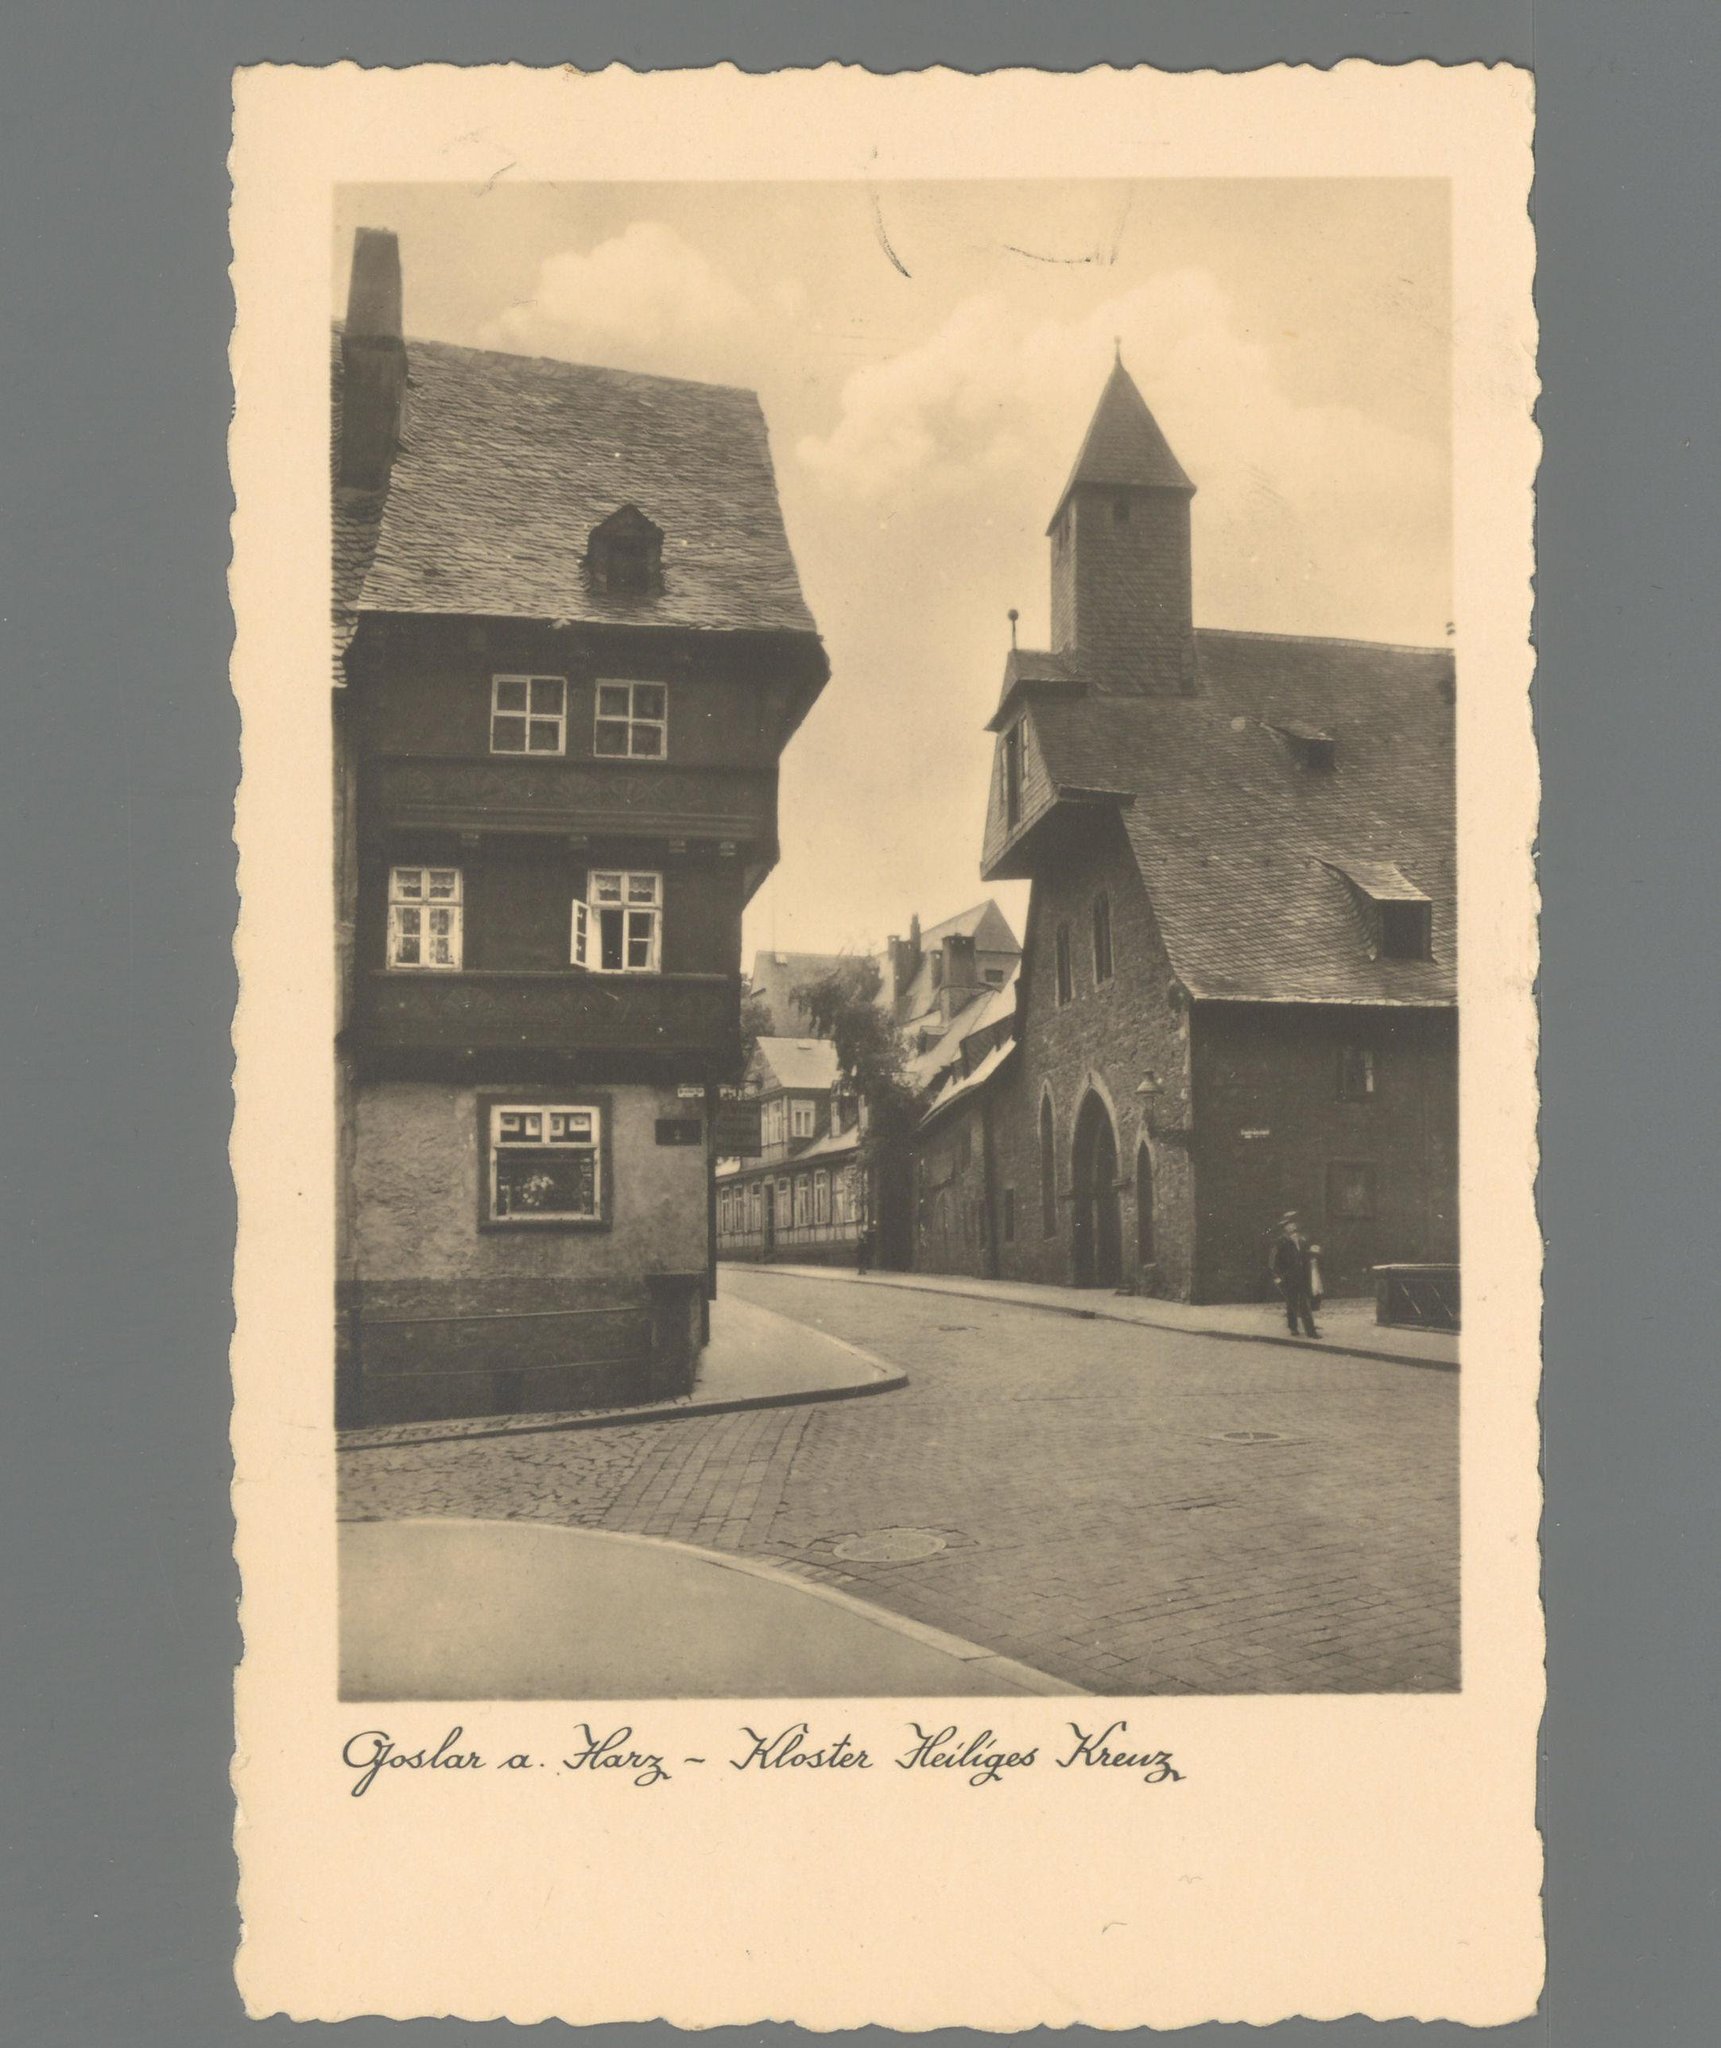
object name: ansichtkaart, prentbriefkaart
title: Goslar a. Harz - Kloster Heiliges Kreuz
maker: Anonymous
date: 1905-1930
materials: photographic support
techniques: photography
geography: dresden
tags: abbey, monastery, convent ~ roman catholic church